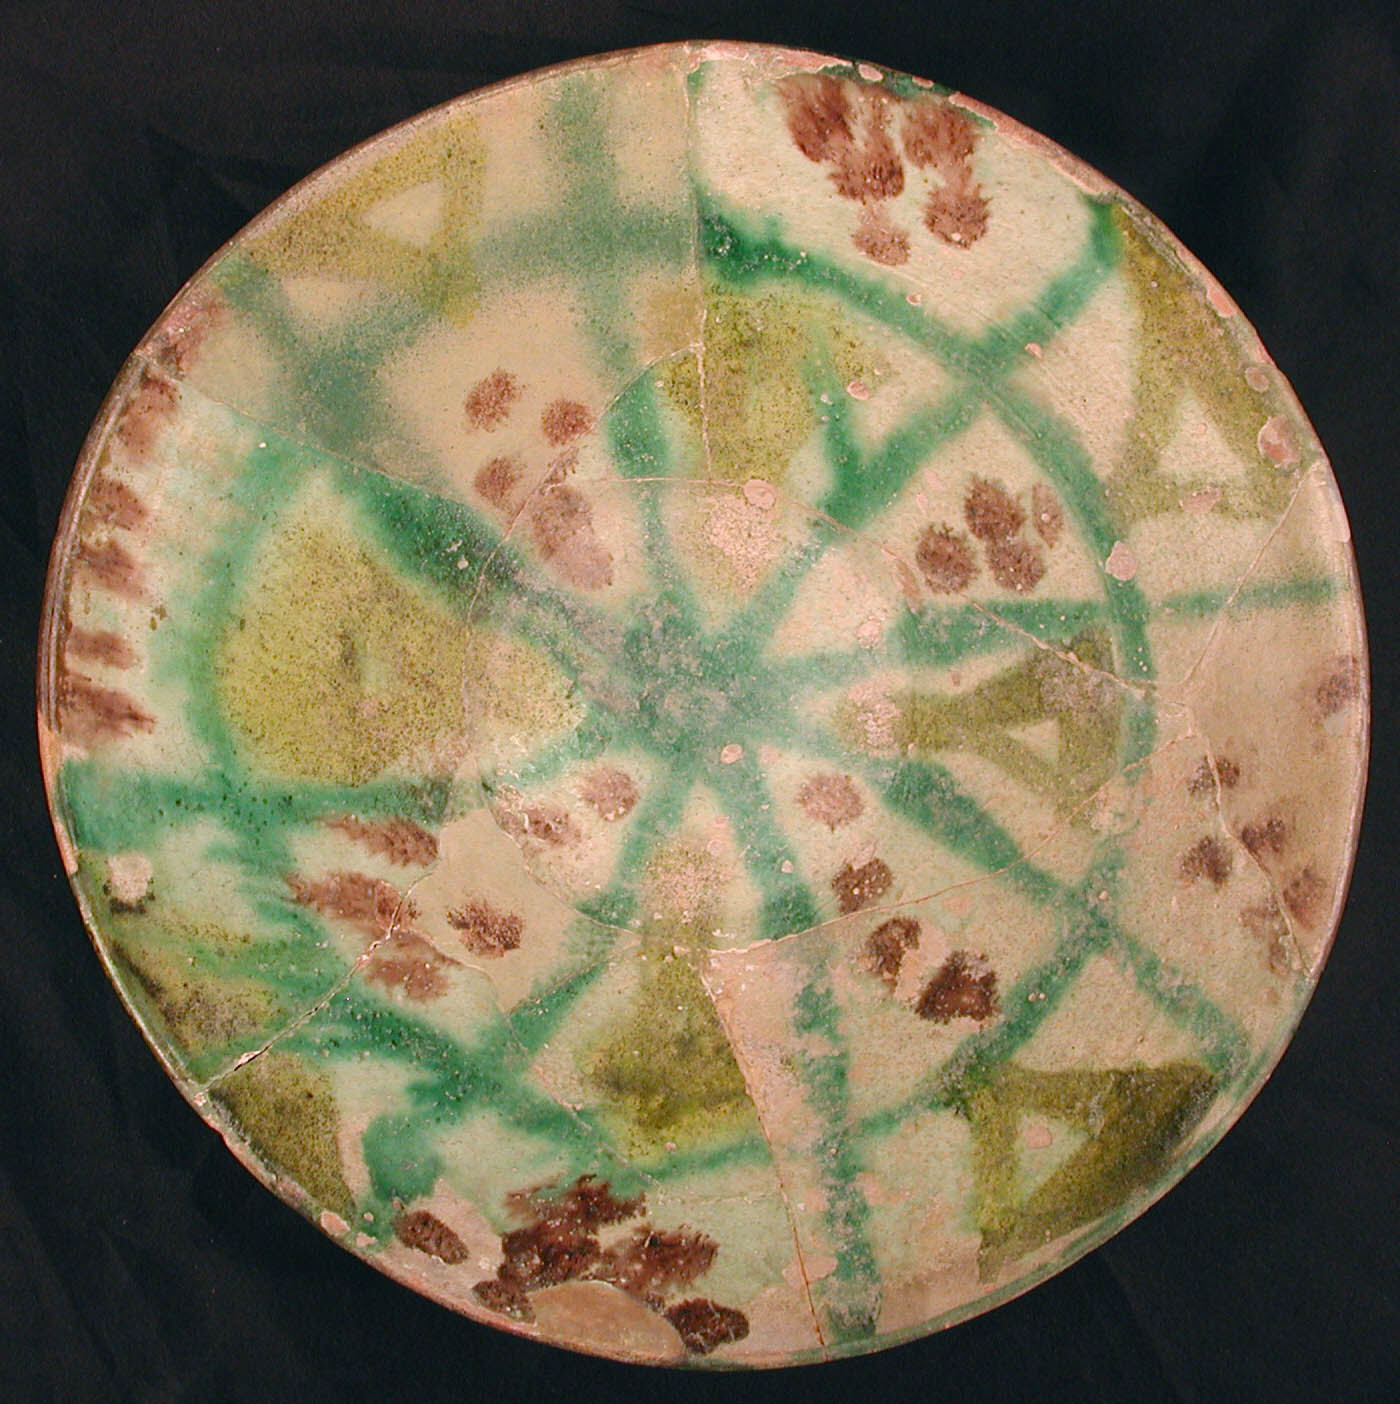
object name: bowl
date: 801-1000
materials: earthenware, glaze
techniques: polychrome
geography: iran